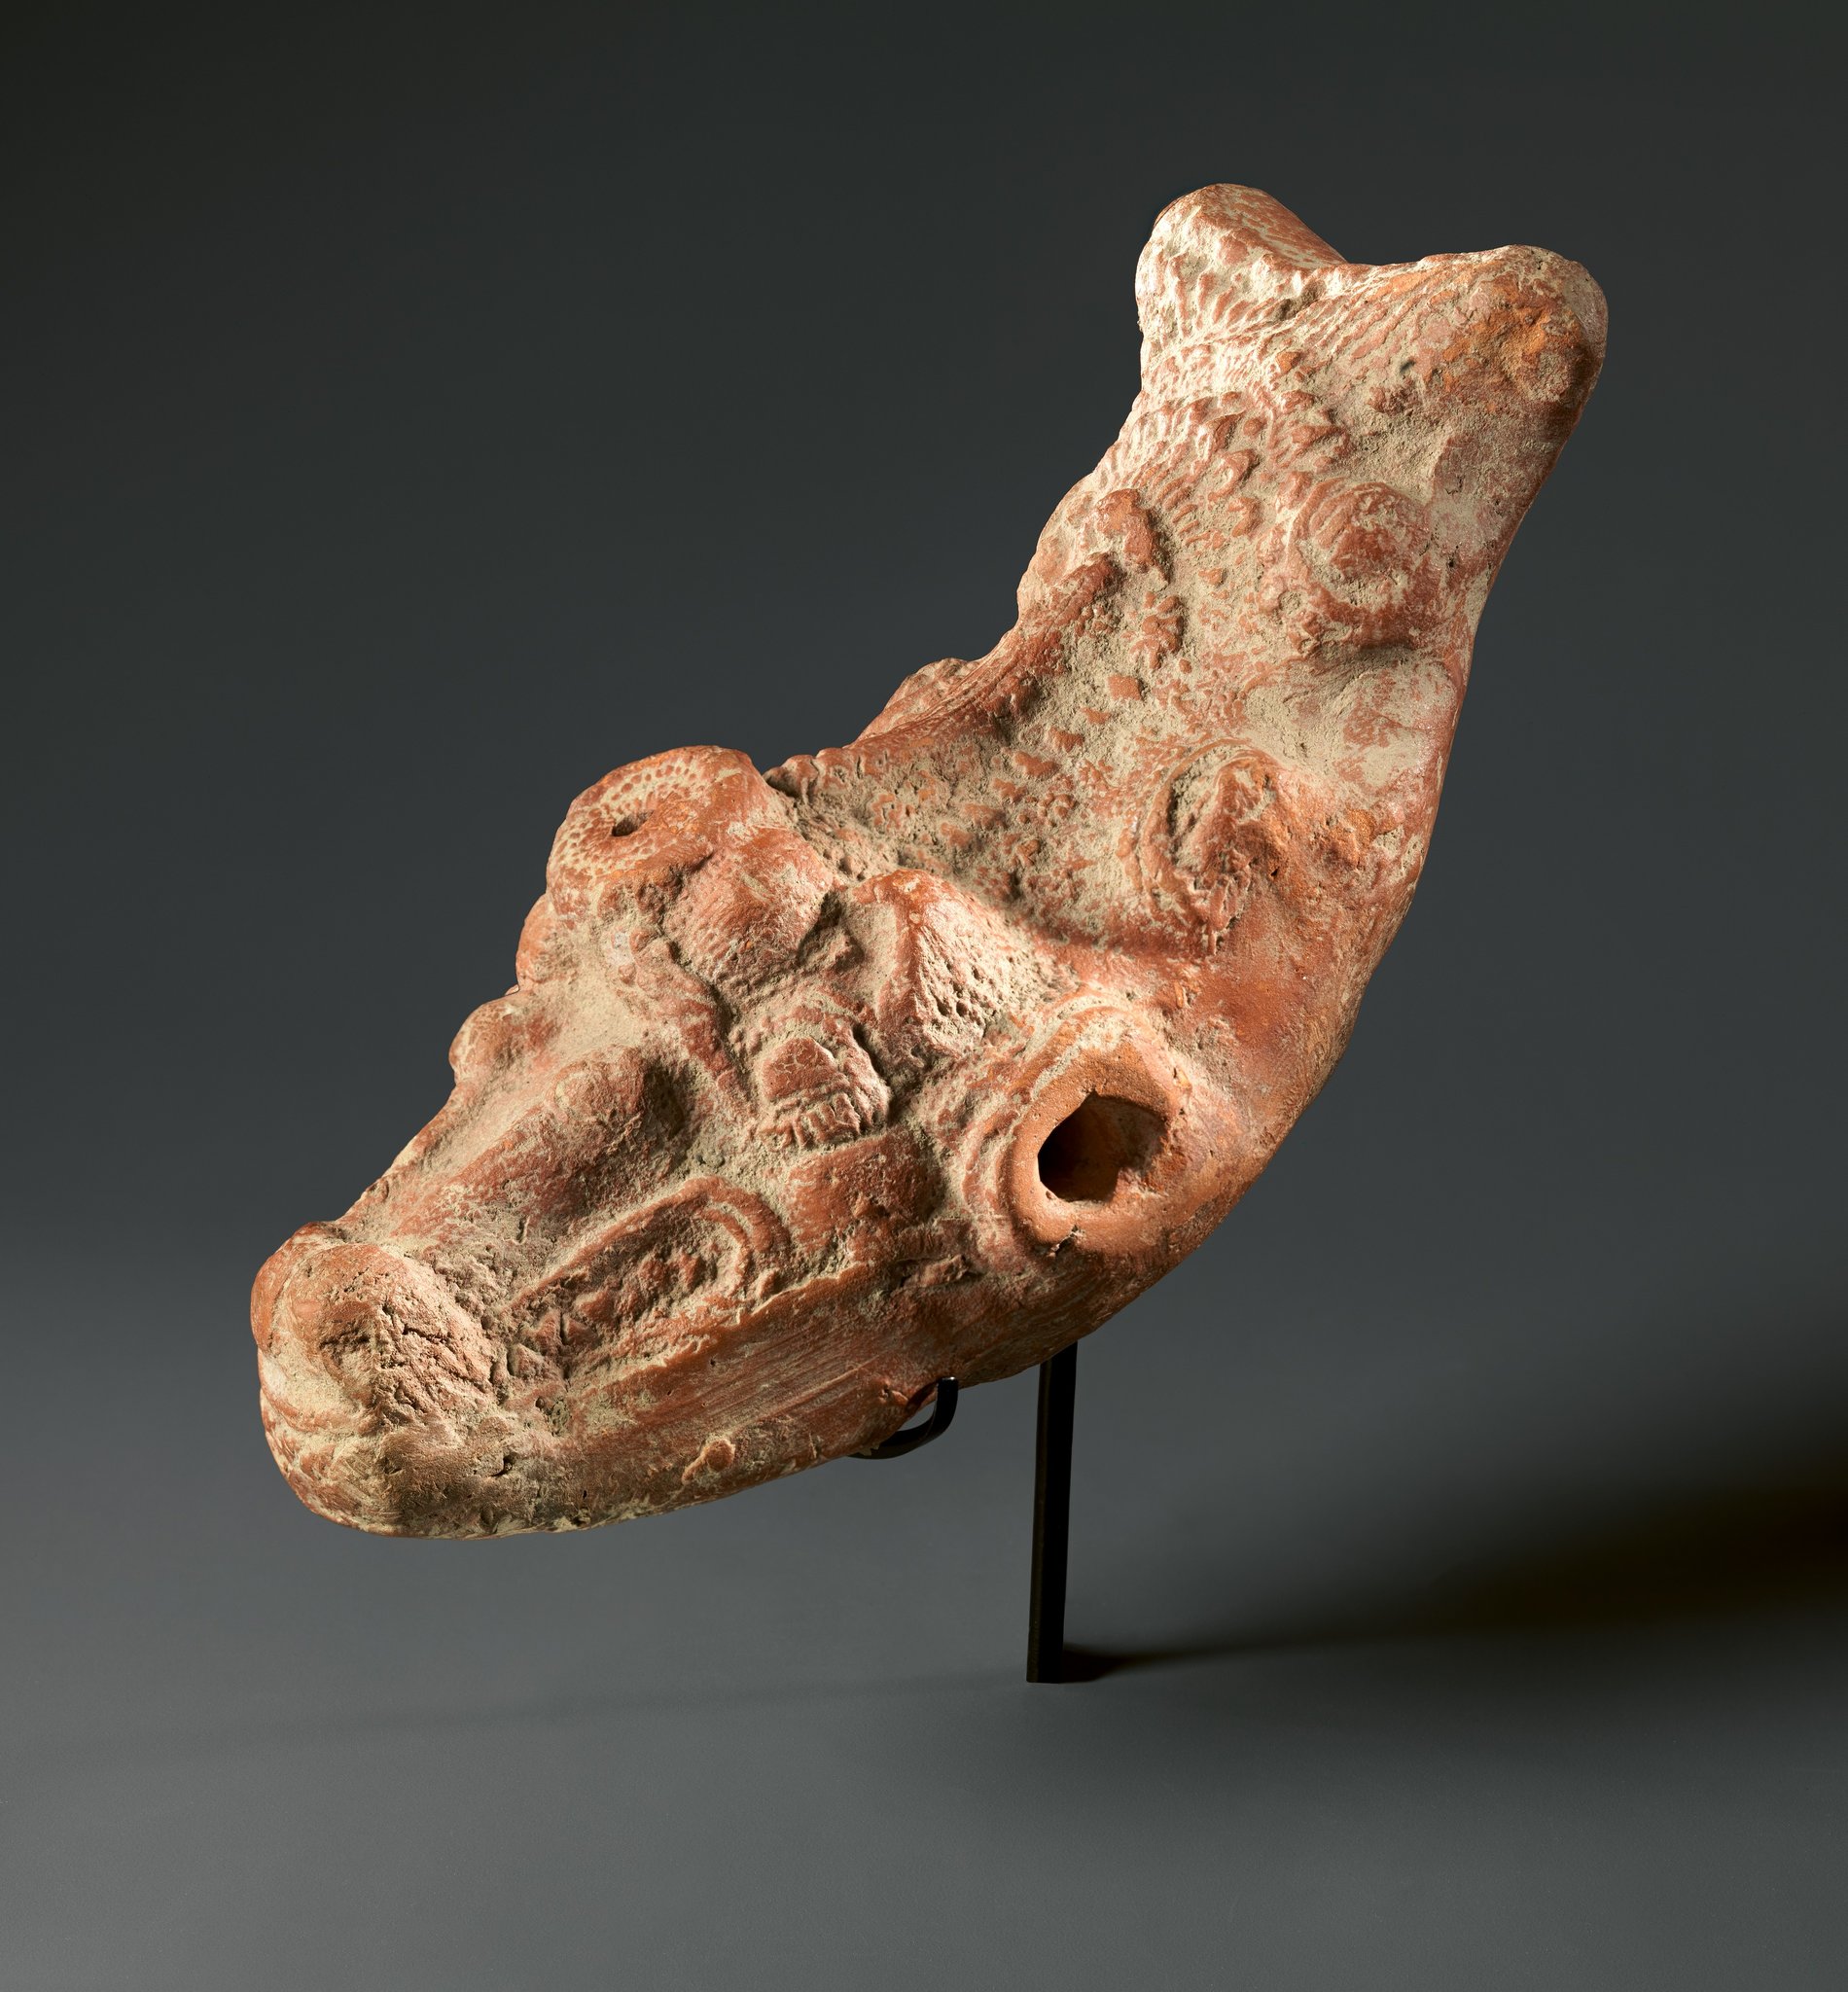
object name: toy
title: Toy in the form of a makara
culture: indian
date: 200-1 BCE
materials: terracotta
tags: shunga,mythical creatures,toys